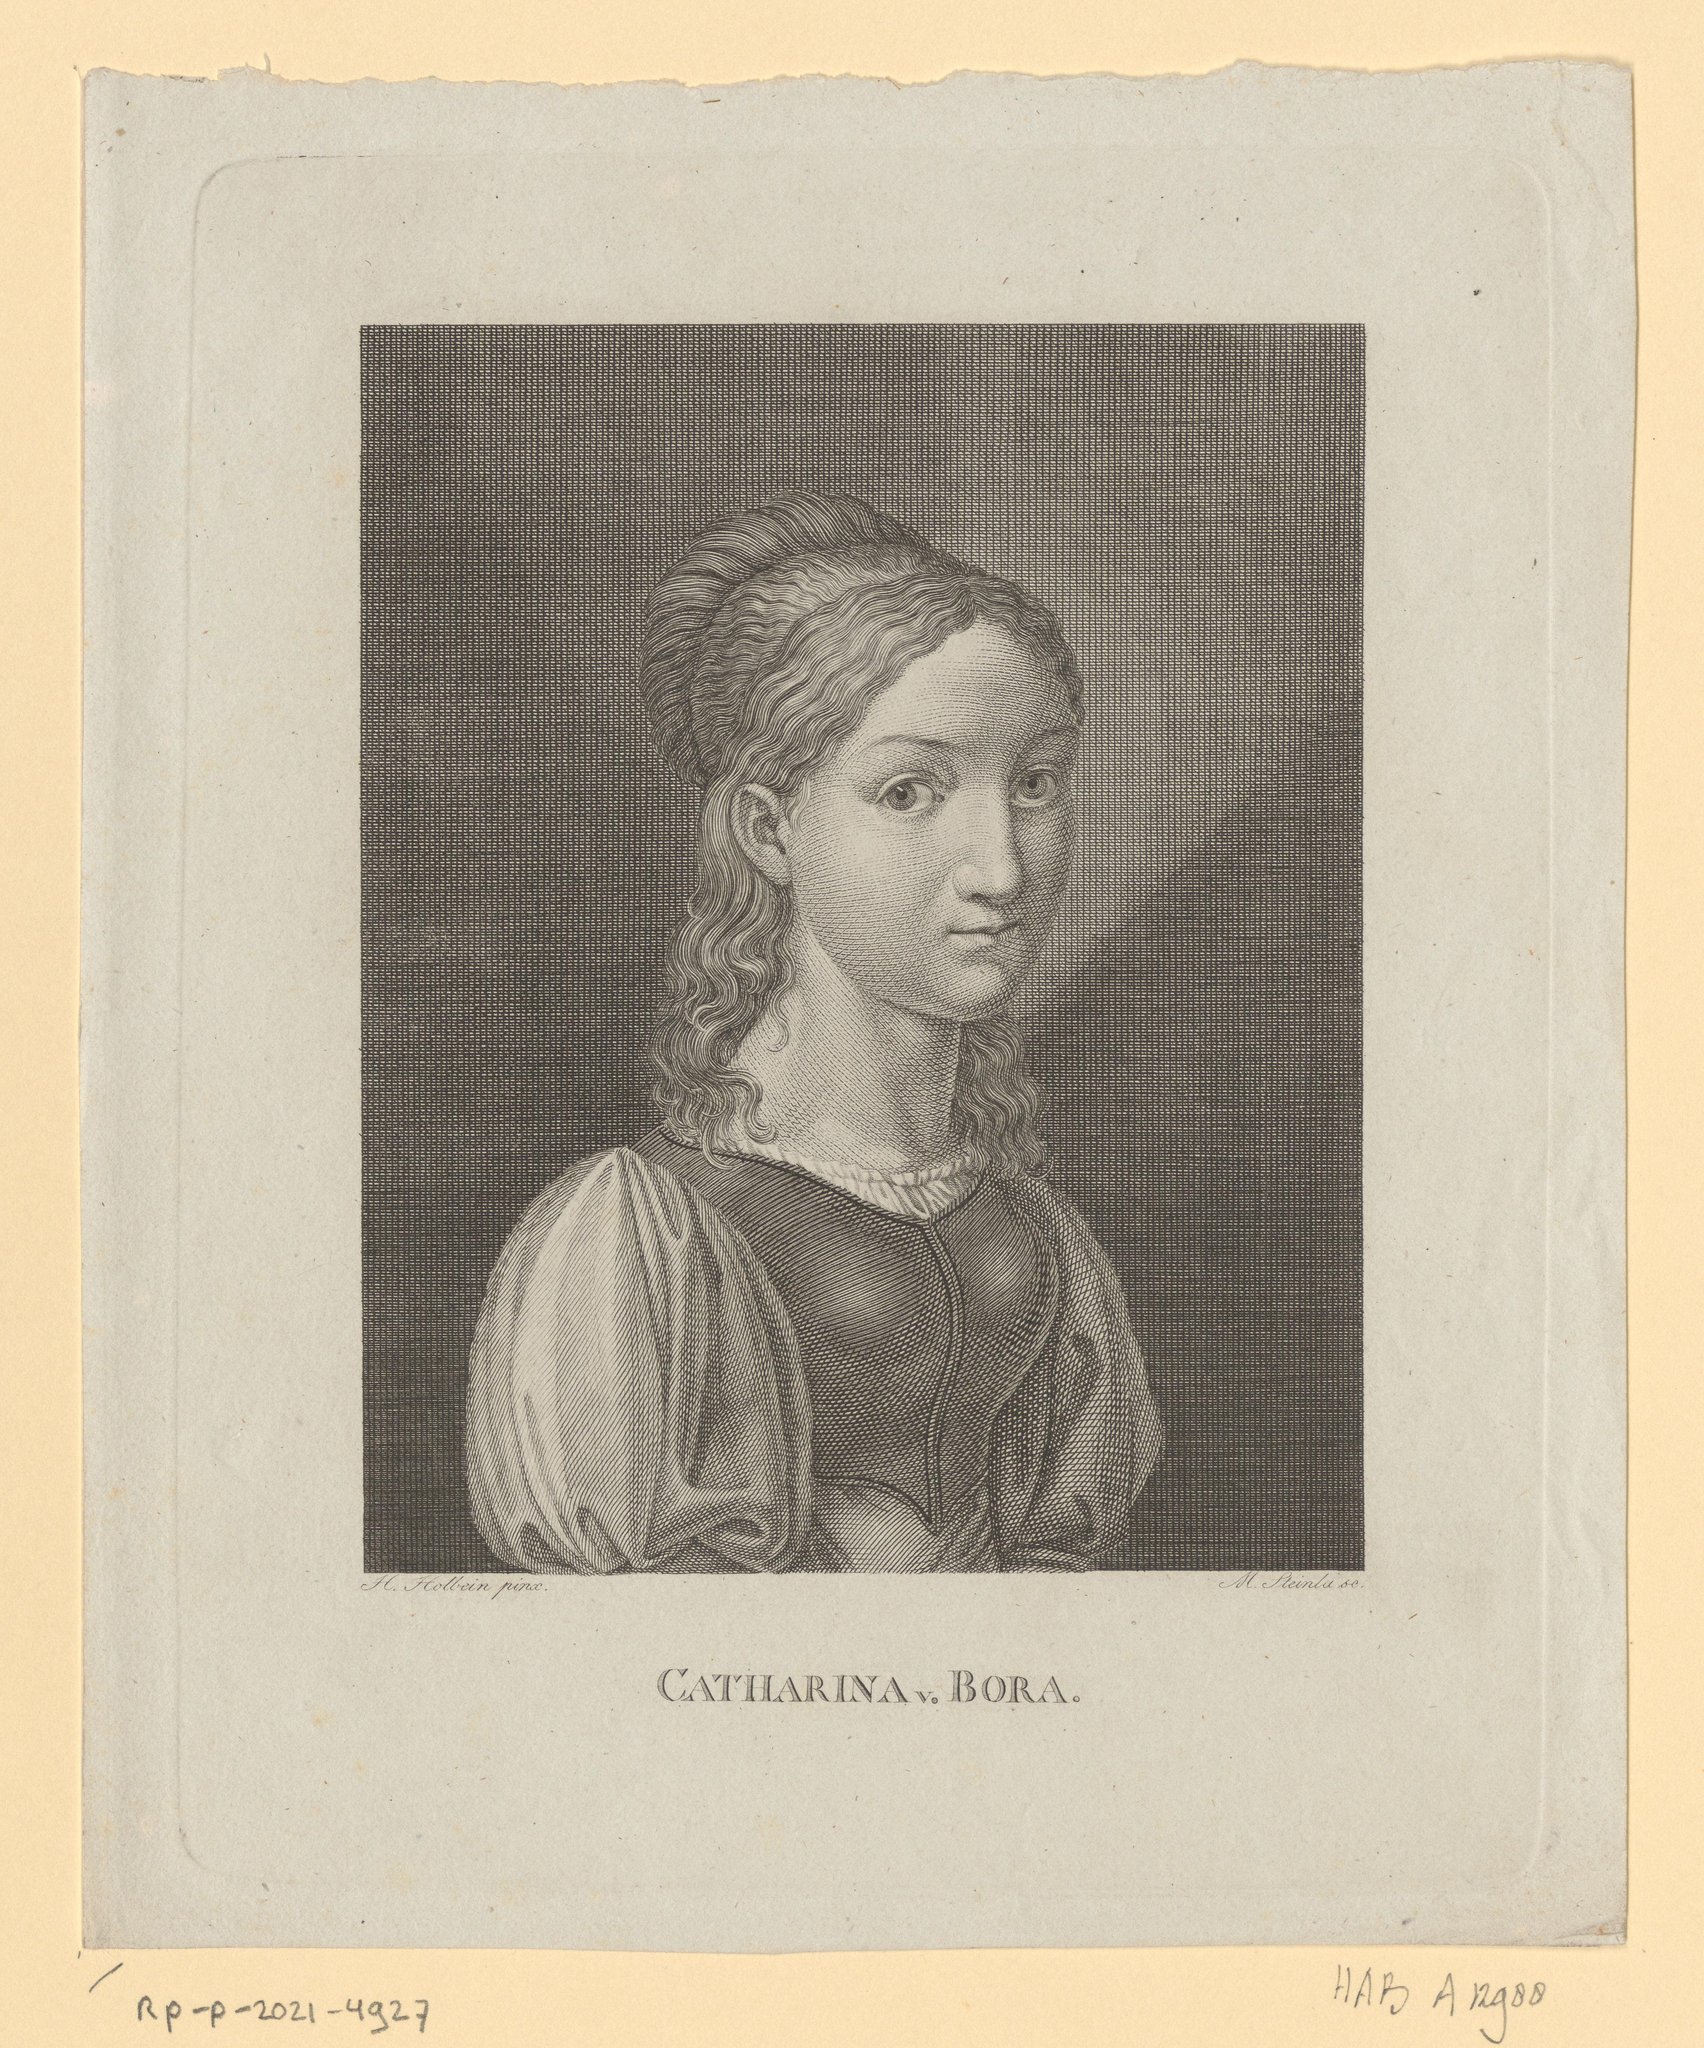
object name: print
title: Portret van Katharina von Bora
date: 1801-1858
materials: paper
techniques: engraving, etching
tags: historical persons - bb - woman